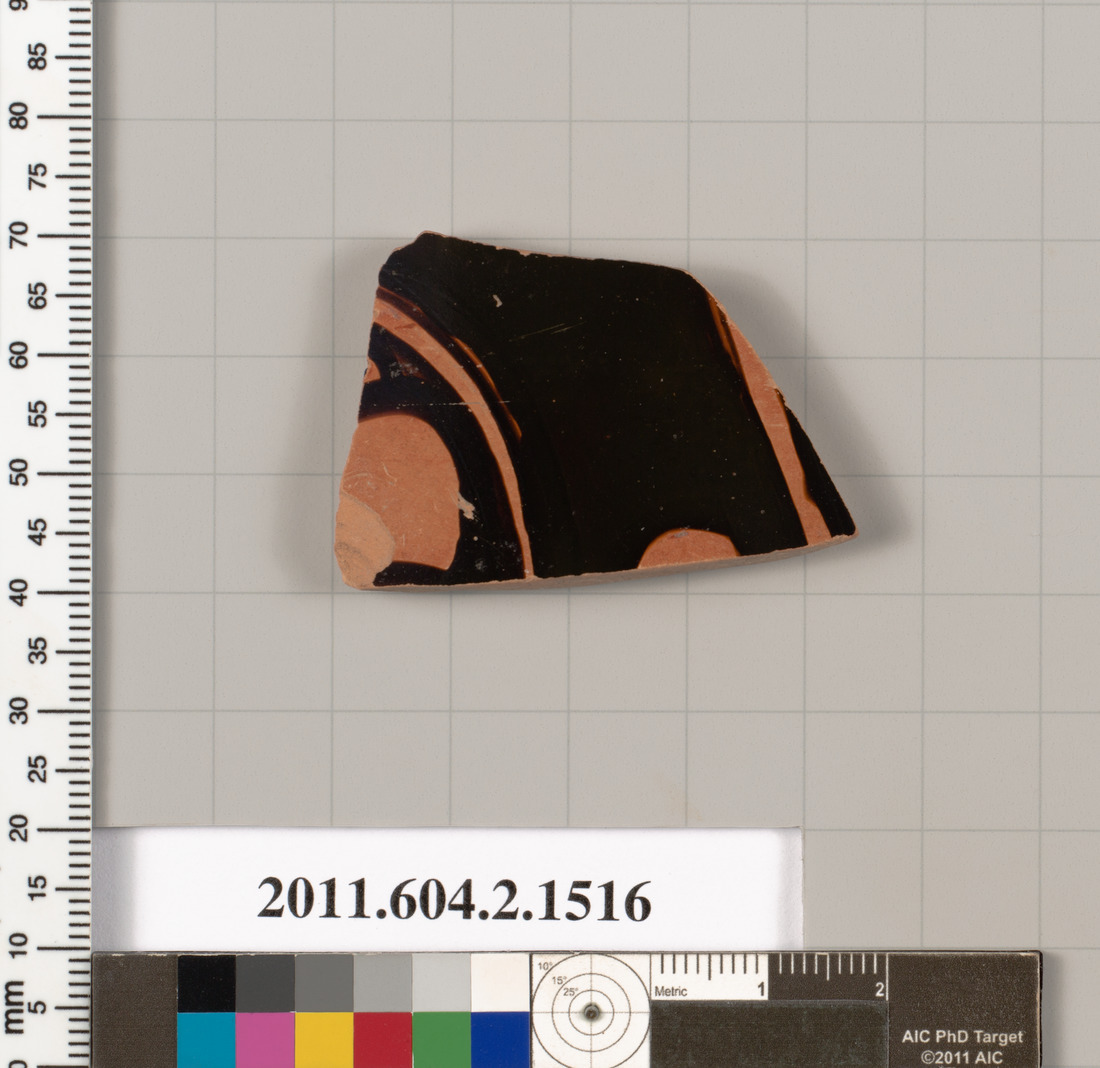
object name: skyphos fragment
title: Terracotta fragment of a skyphos (deep drinking cup)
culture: greek, attic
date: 450-401 BCE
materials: terracotta